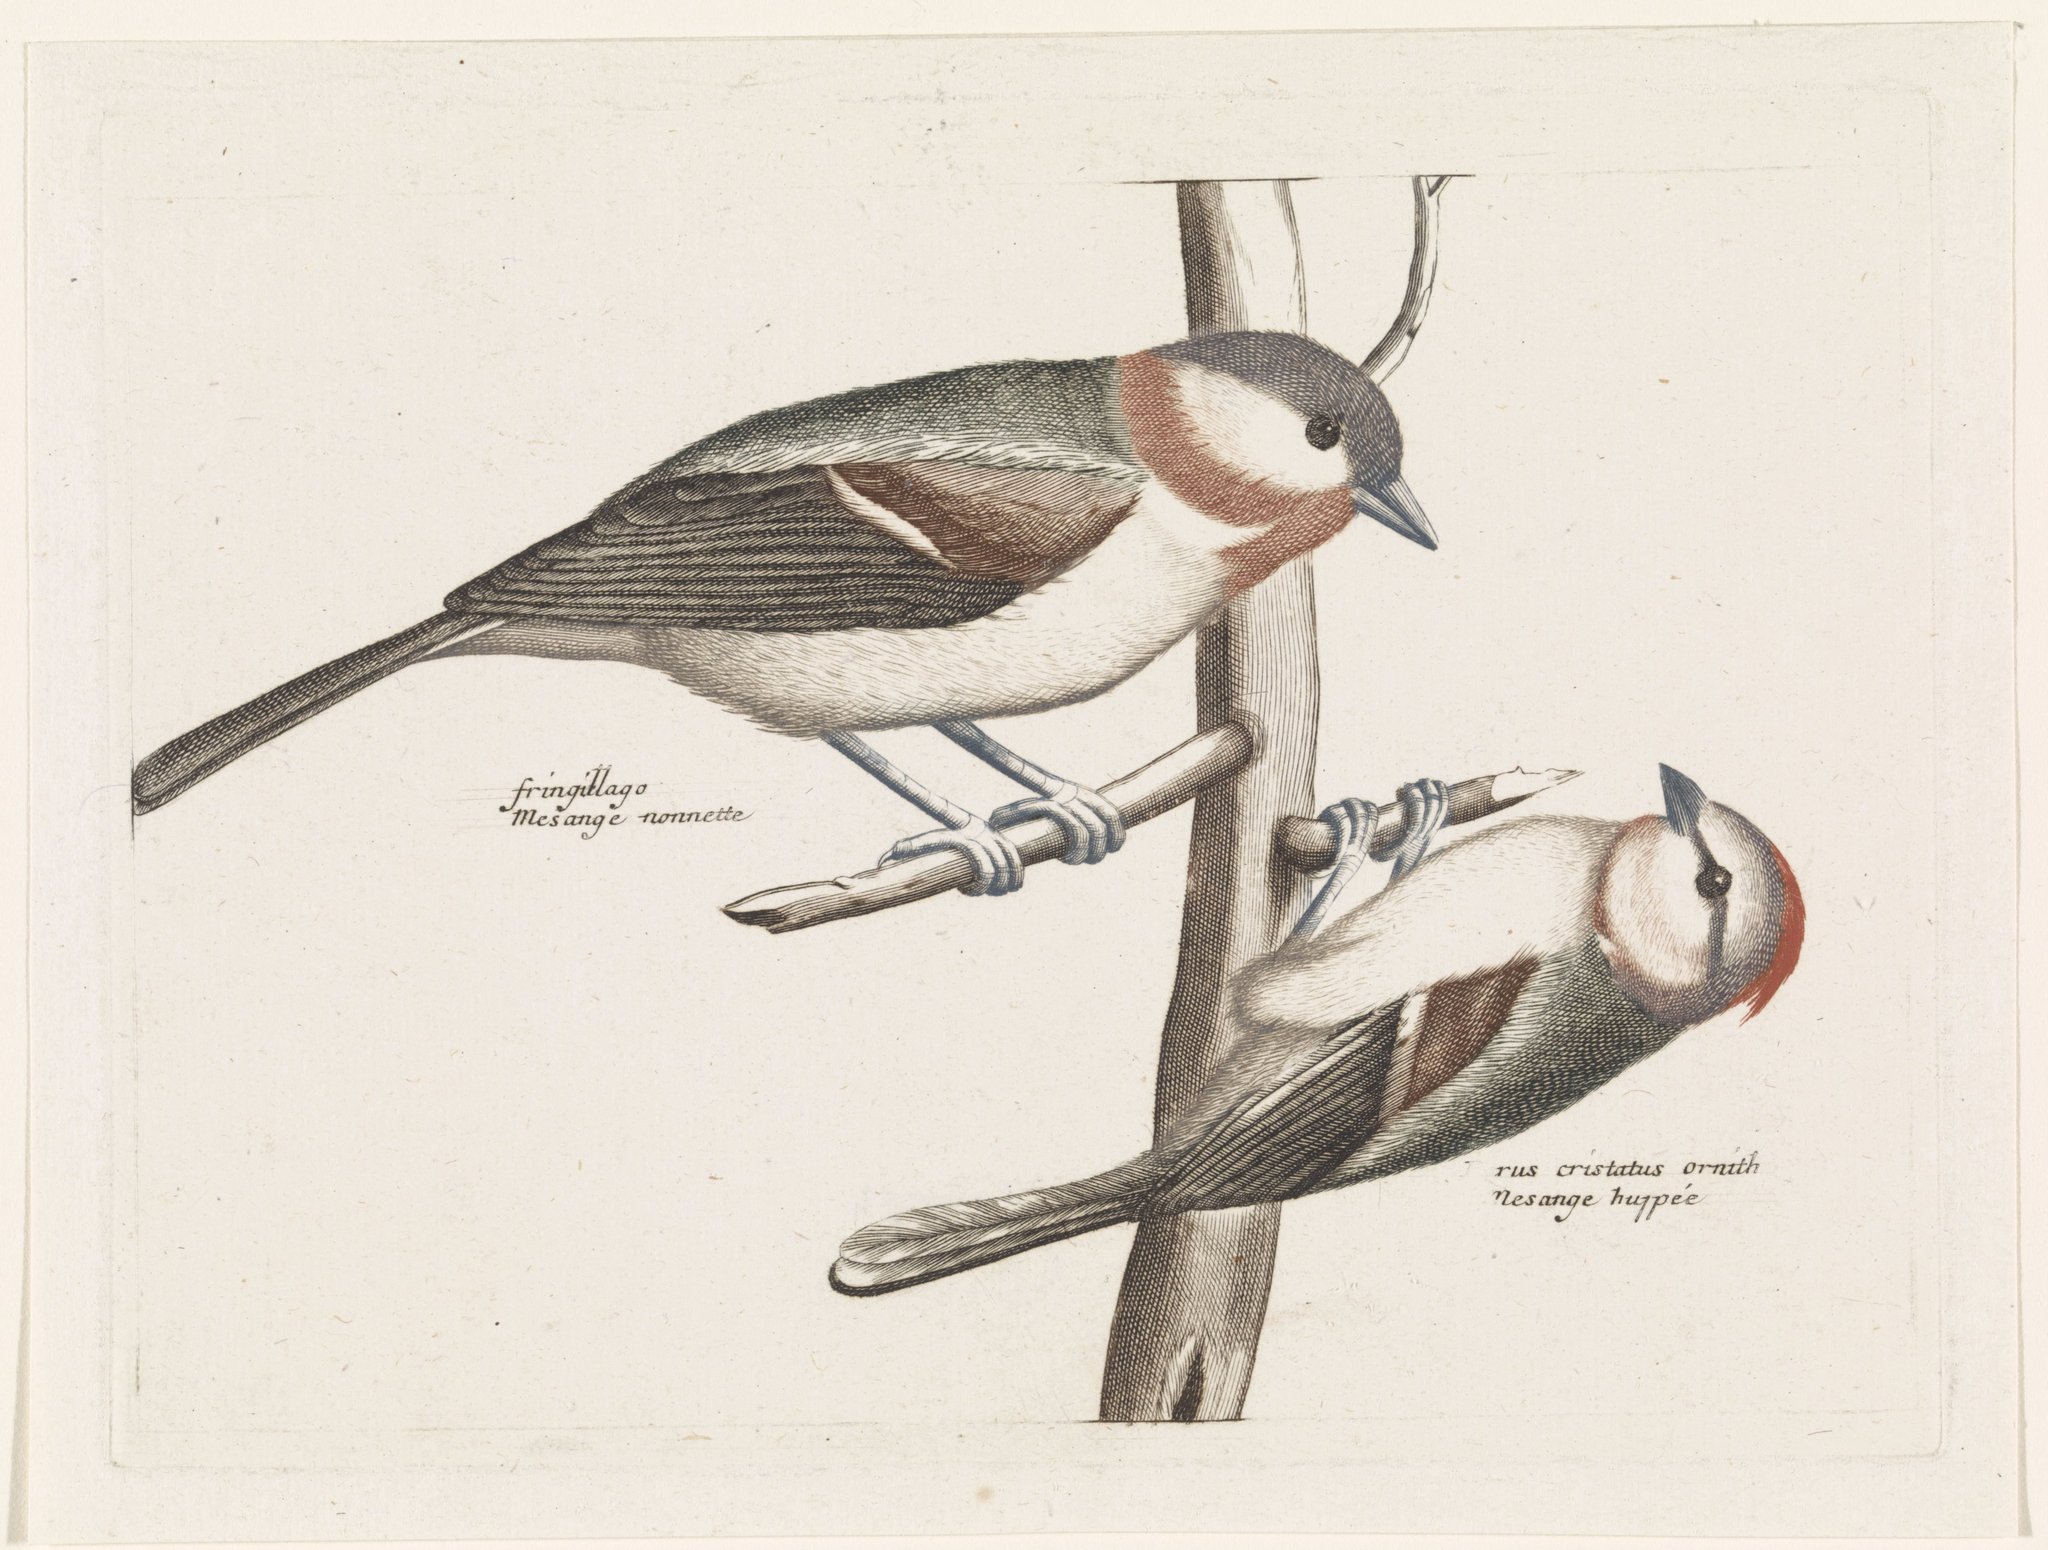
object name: print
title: Glanskop en kuifmees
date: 1688-1698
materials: paper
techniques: printing, engraving, lithography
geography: netherlands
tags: song-birds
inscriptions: collector's mark: Lugt 2228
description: Een glanskop en een kuifmees op een tak. Daarnaast hun namen in het Latijn en het Frans.